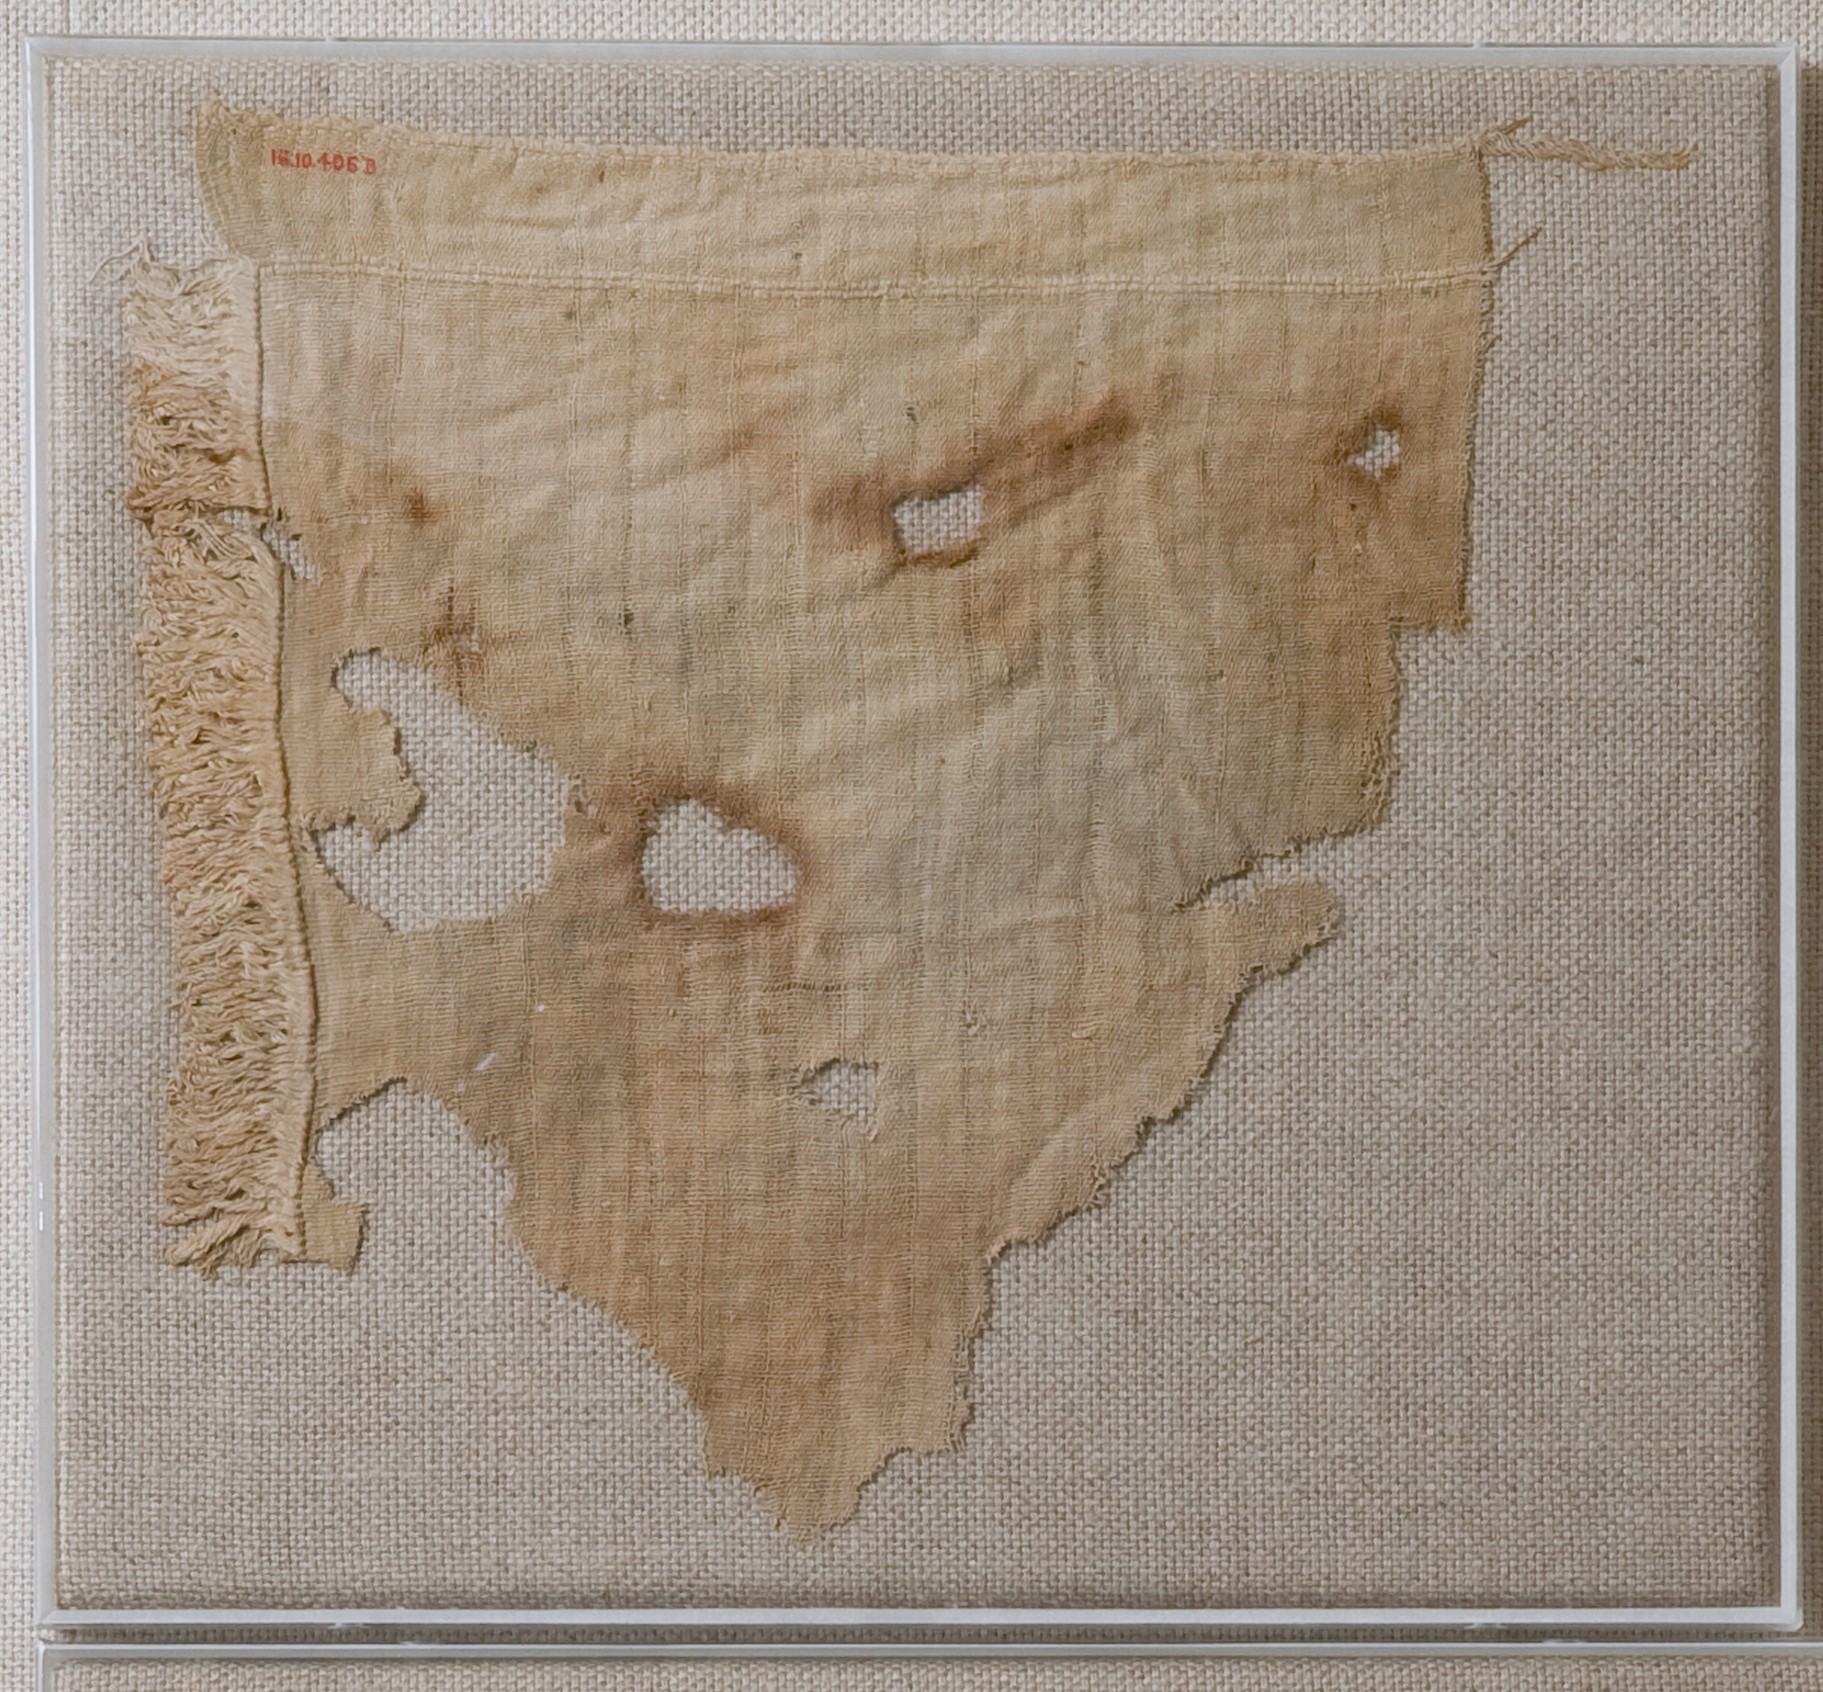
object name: linen fragment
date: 1635-1458 BCE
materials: linen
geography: egypt